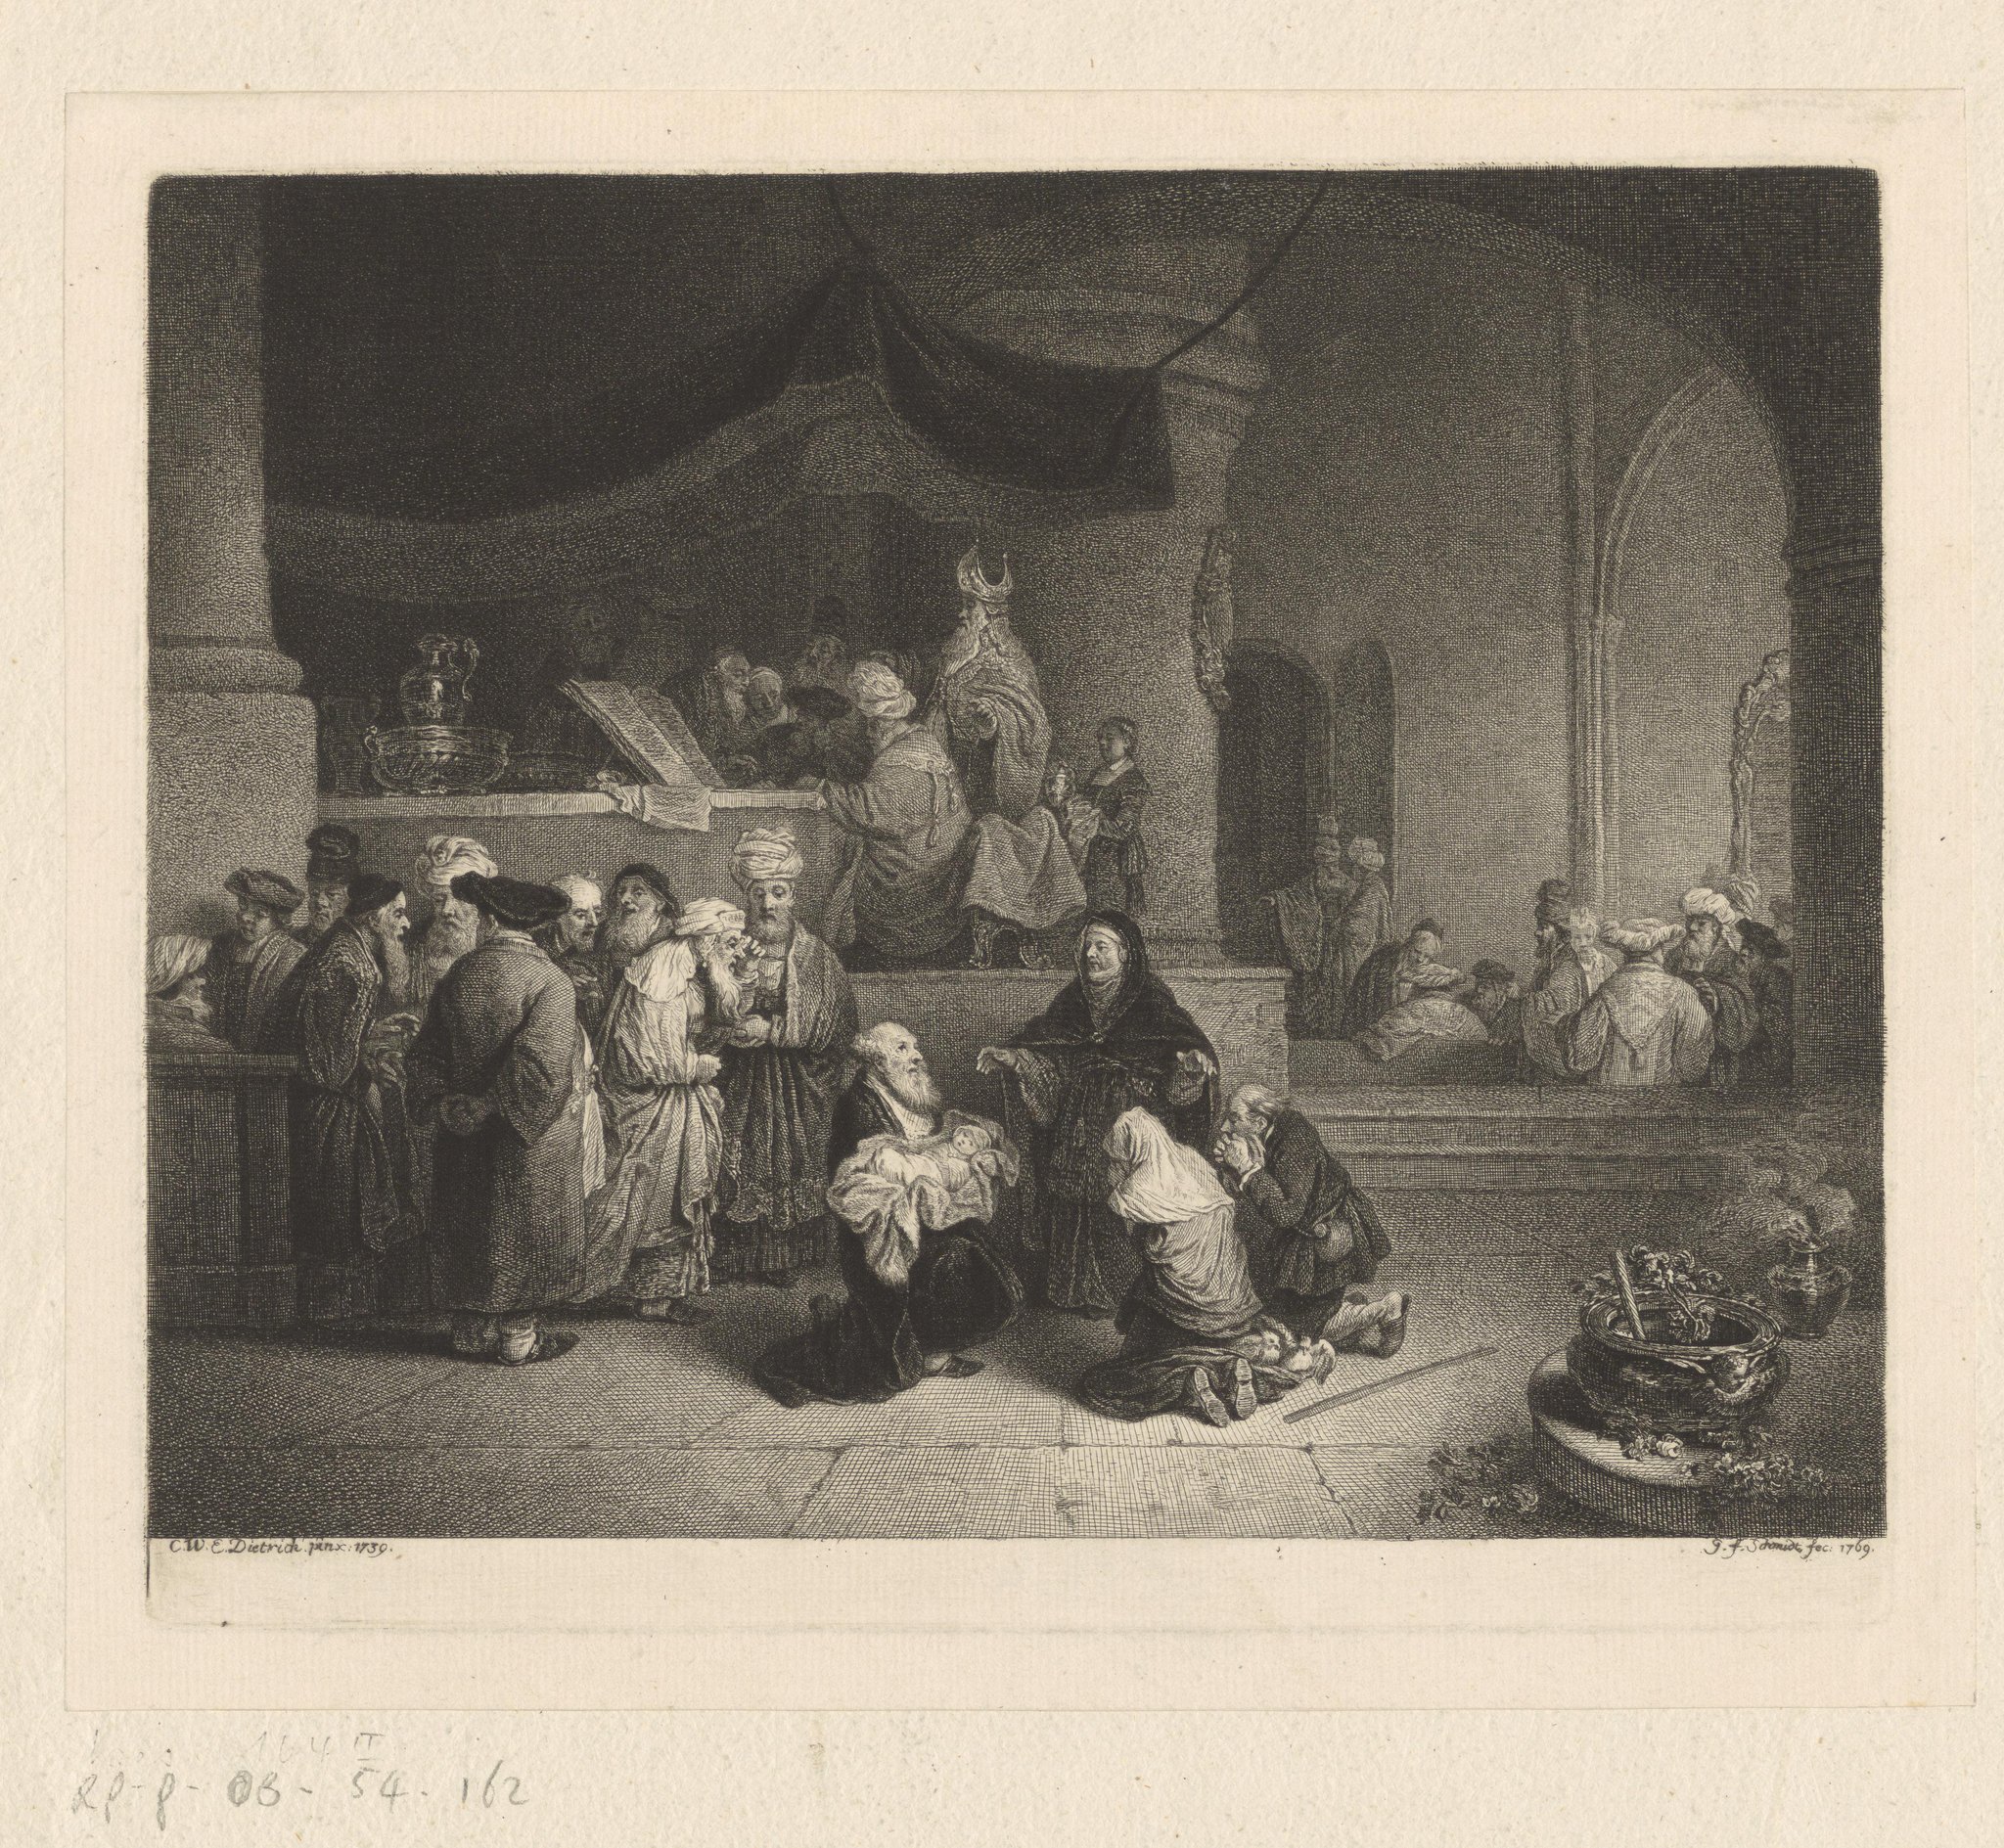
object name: print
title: Presentatie van Christus in de tempel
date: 1769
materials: paper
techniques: etching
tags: presentation of the christ-child in the temple, usually simeon (and anna) present (luke 2:22-39)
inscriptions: collector's mark: Lugt 240